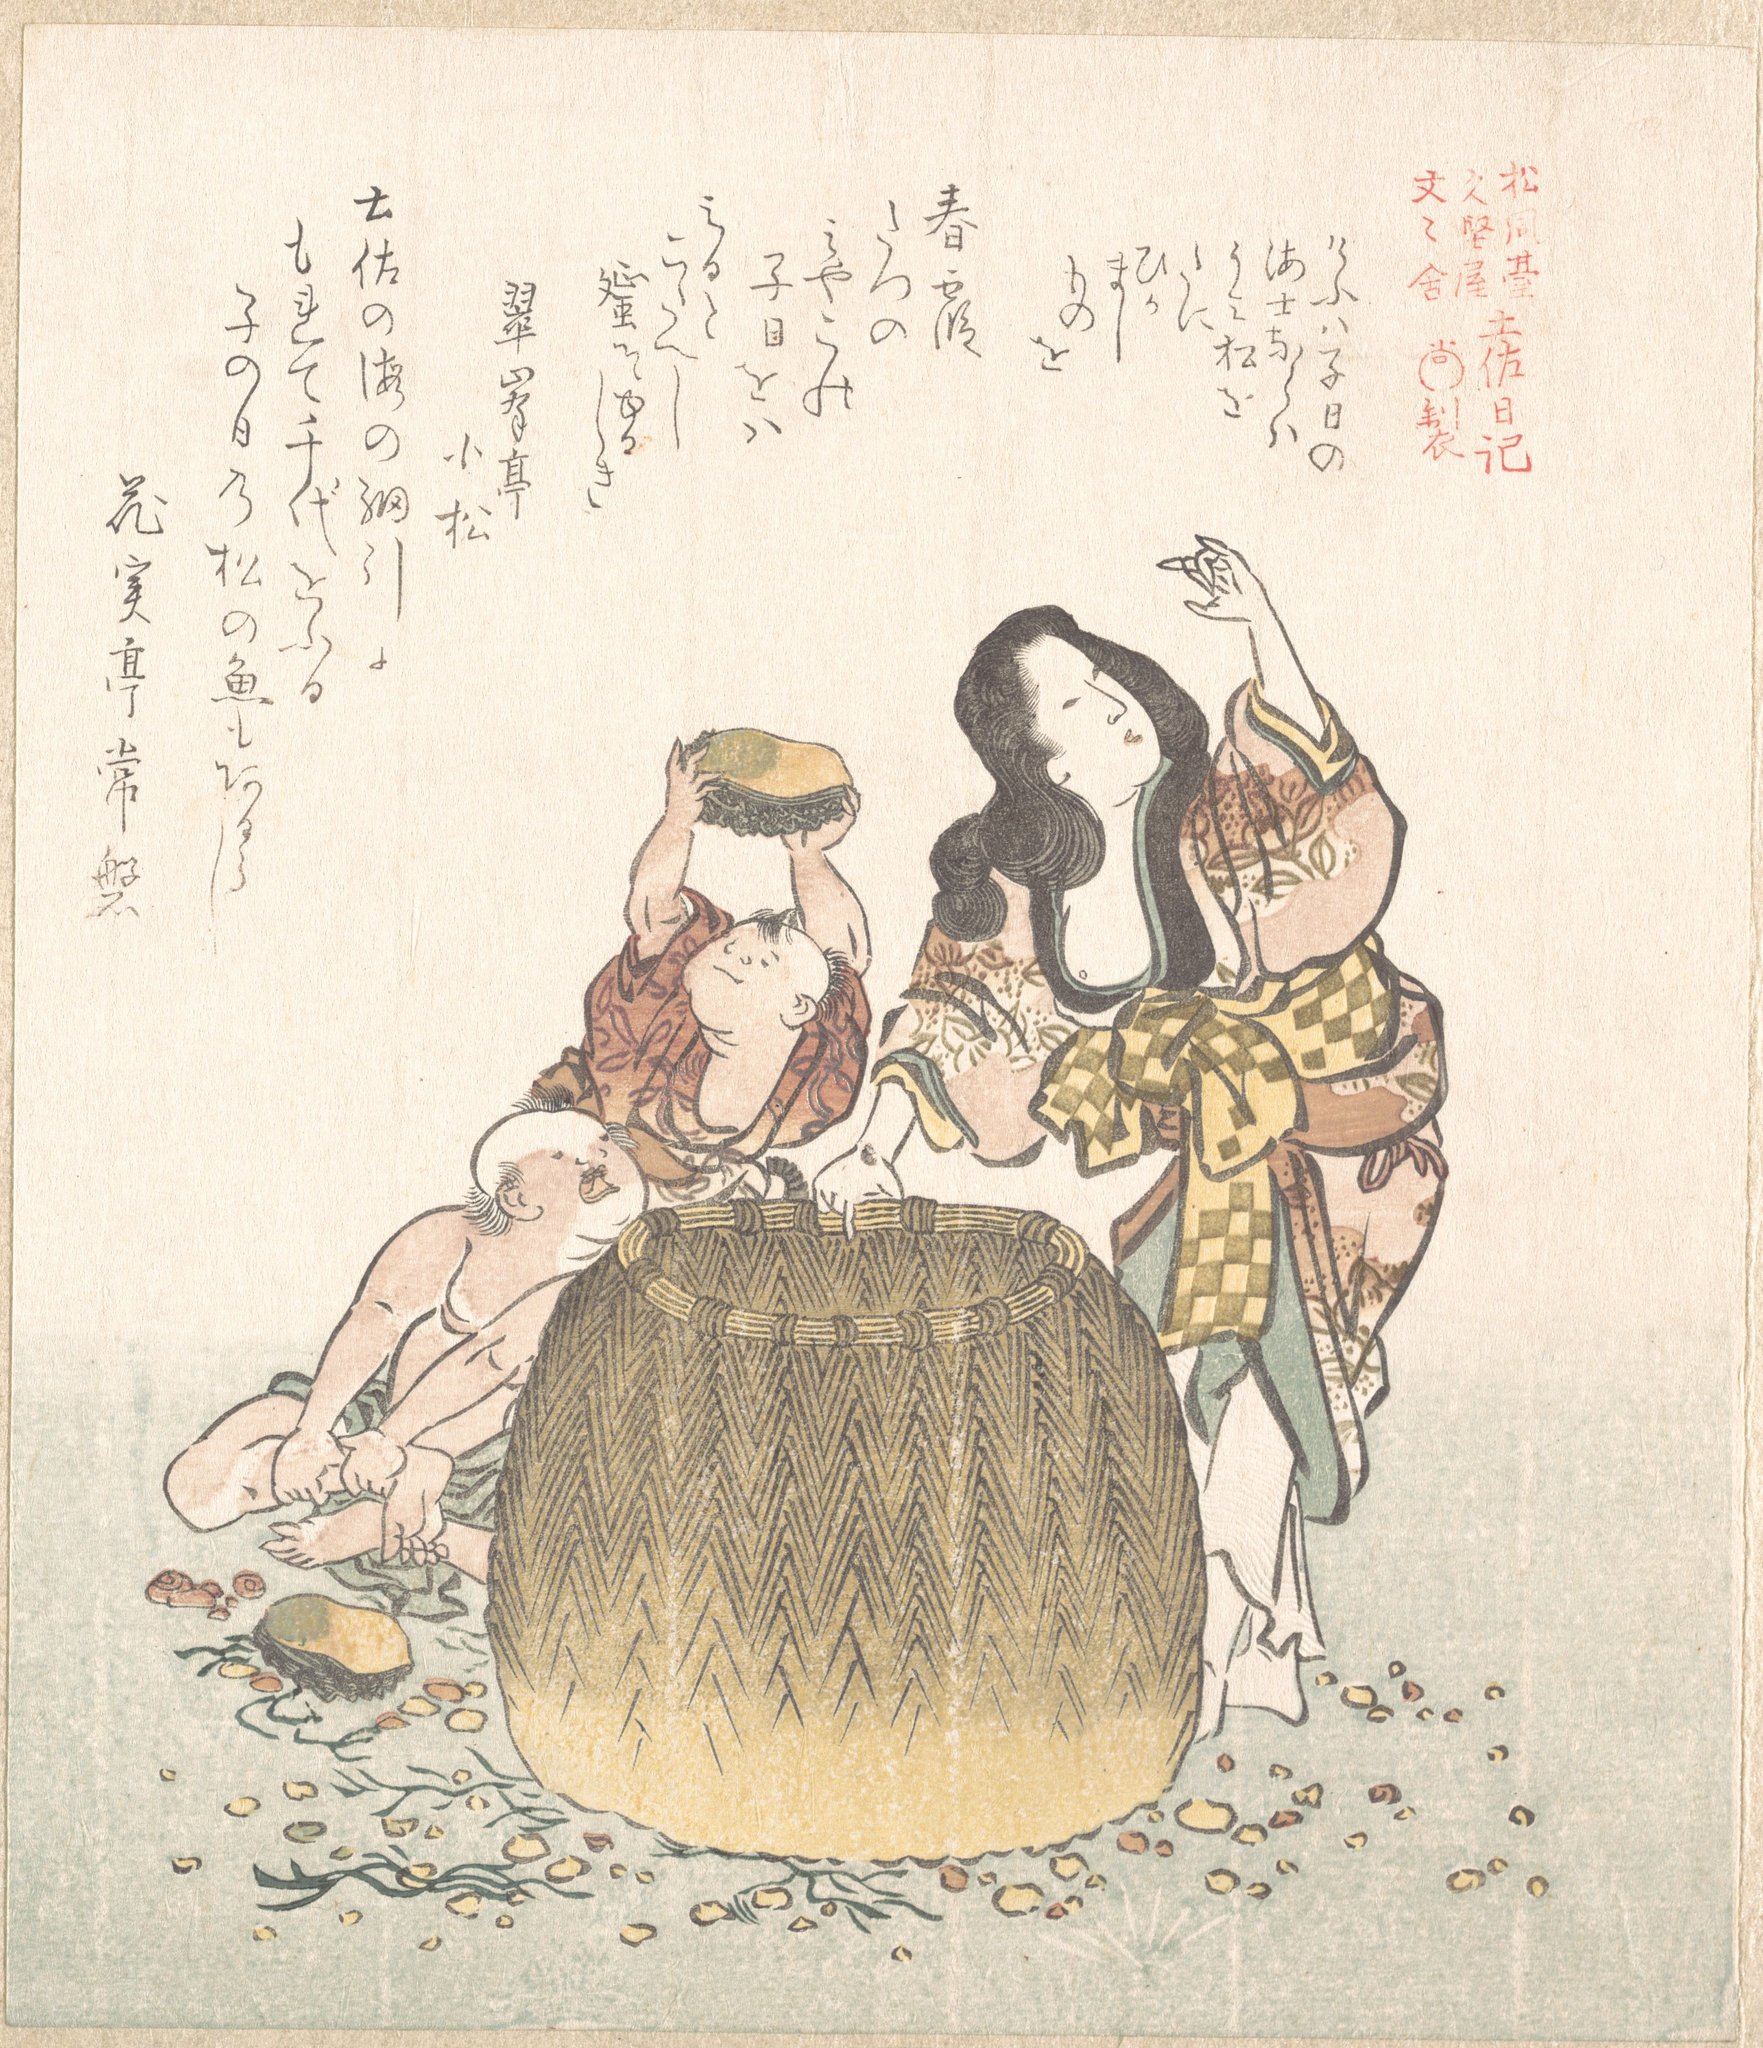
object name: woodblock print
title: Fisherwoman with a Basket and Two Boys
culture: japanese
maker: kubo shunman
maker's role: artist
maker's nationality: japanese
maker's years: 1757-1820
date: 1801-1900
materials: ink, paper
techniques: surimono, woodblock print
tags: boys,women